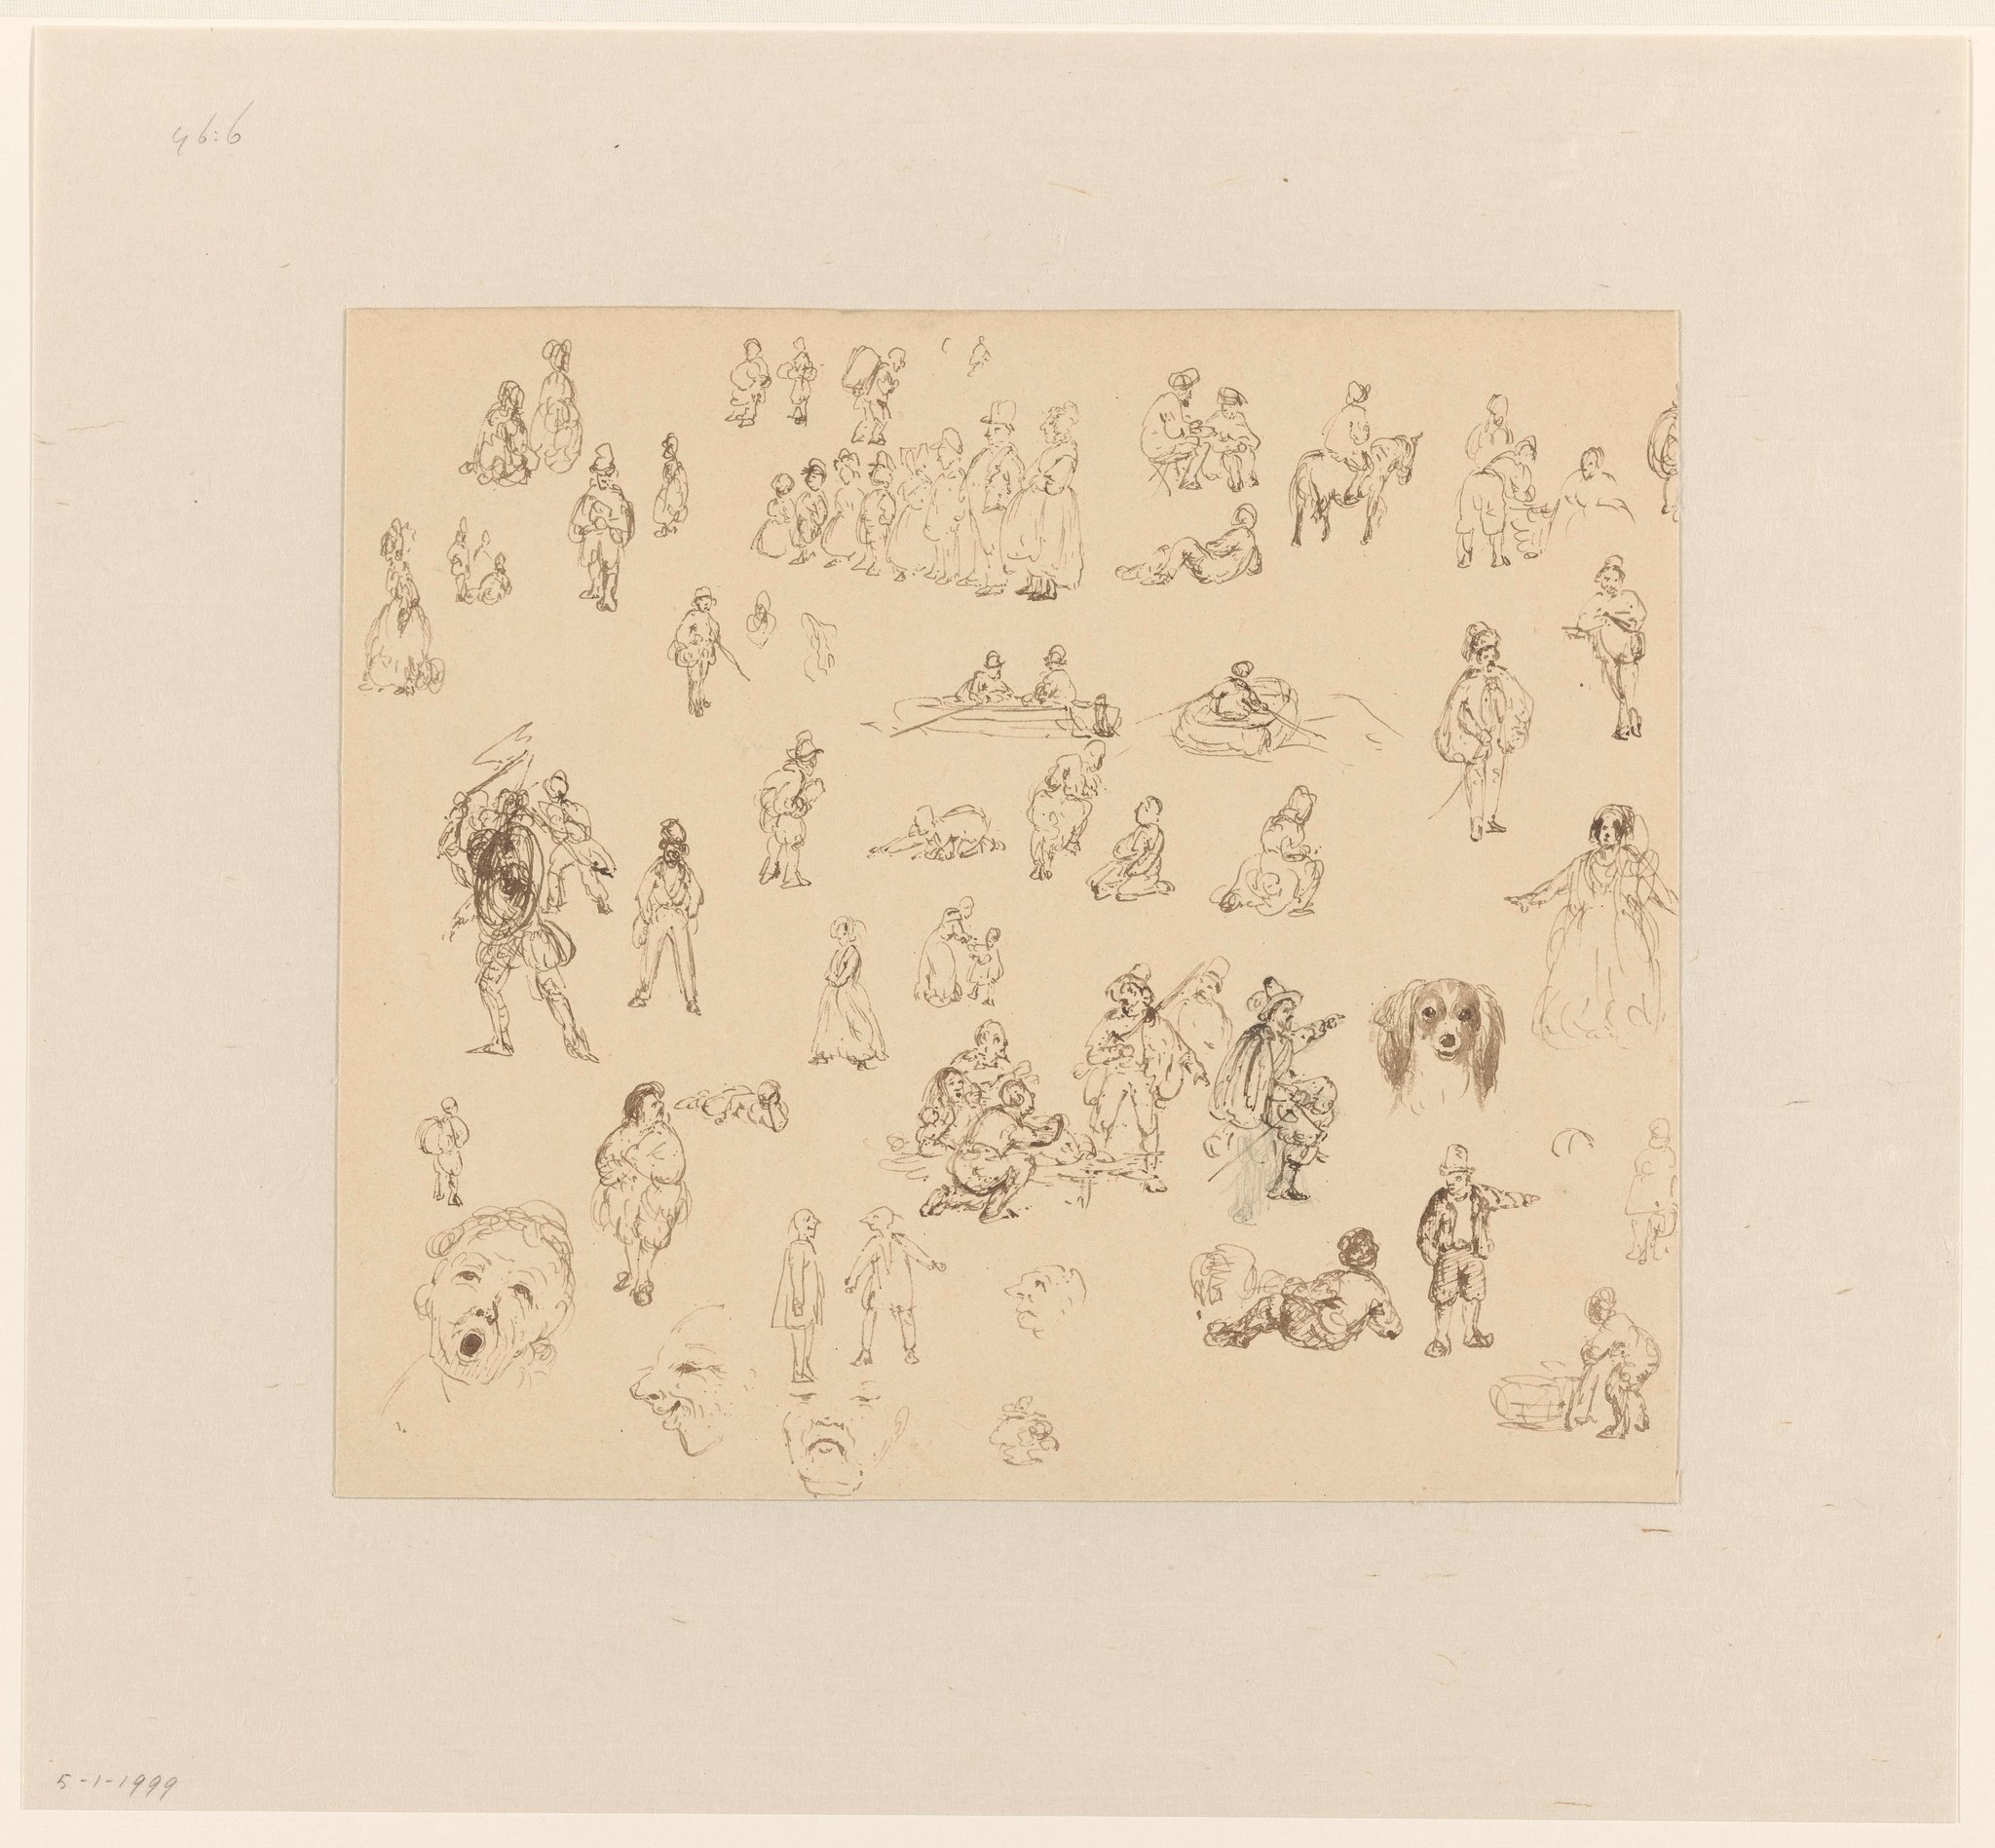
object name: drawing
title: Schetsblad met vele figuren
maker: jan van ravenswaay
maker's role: draughtsman, painter, print maker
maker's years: 1789-1869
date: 1799-1869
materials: ink, paper, pencil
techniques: pen